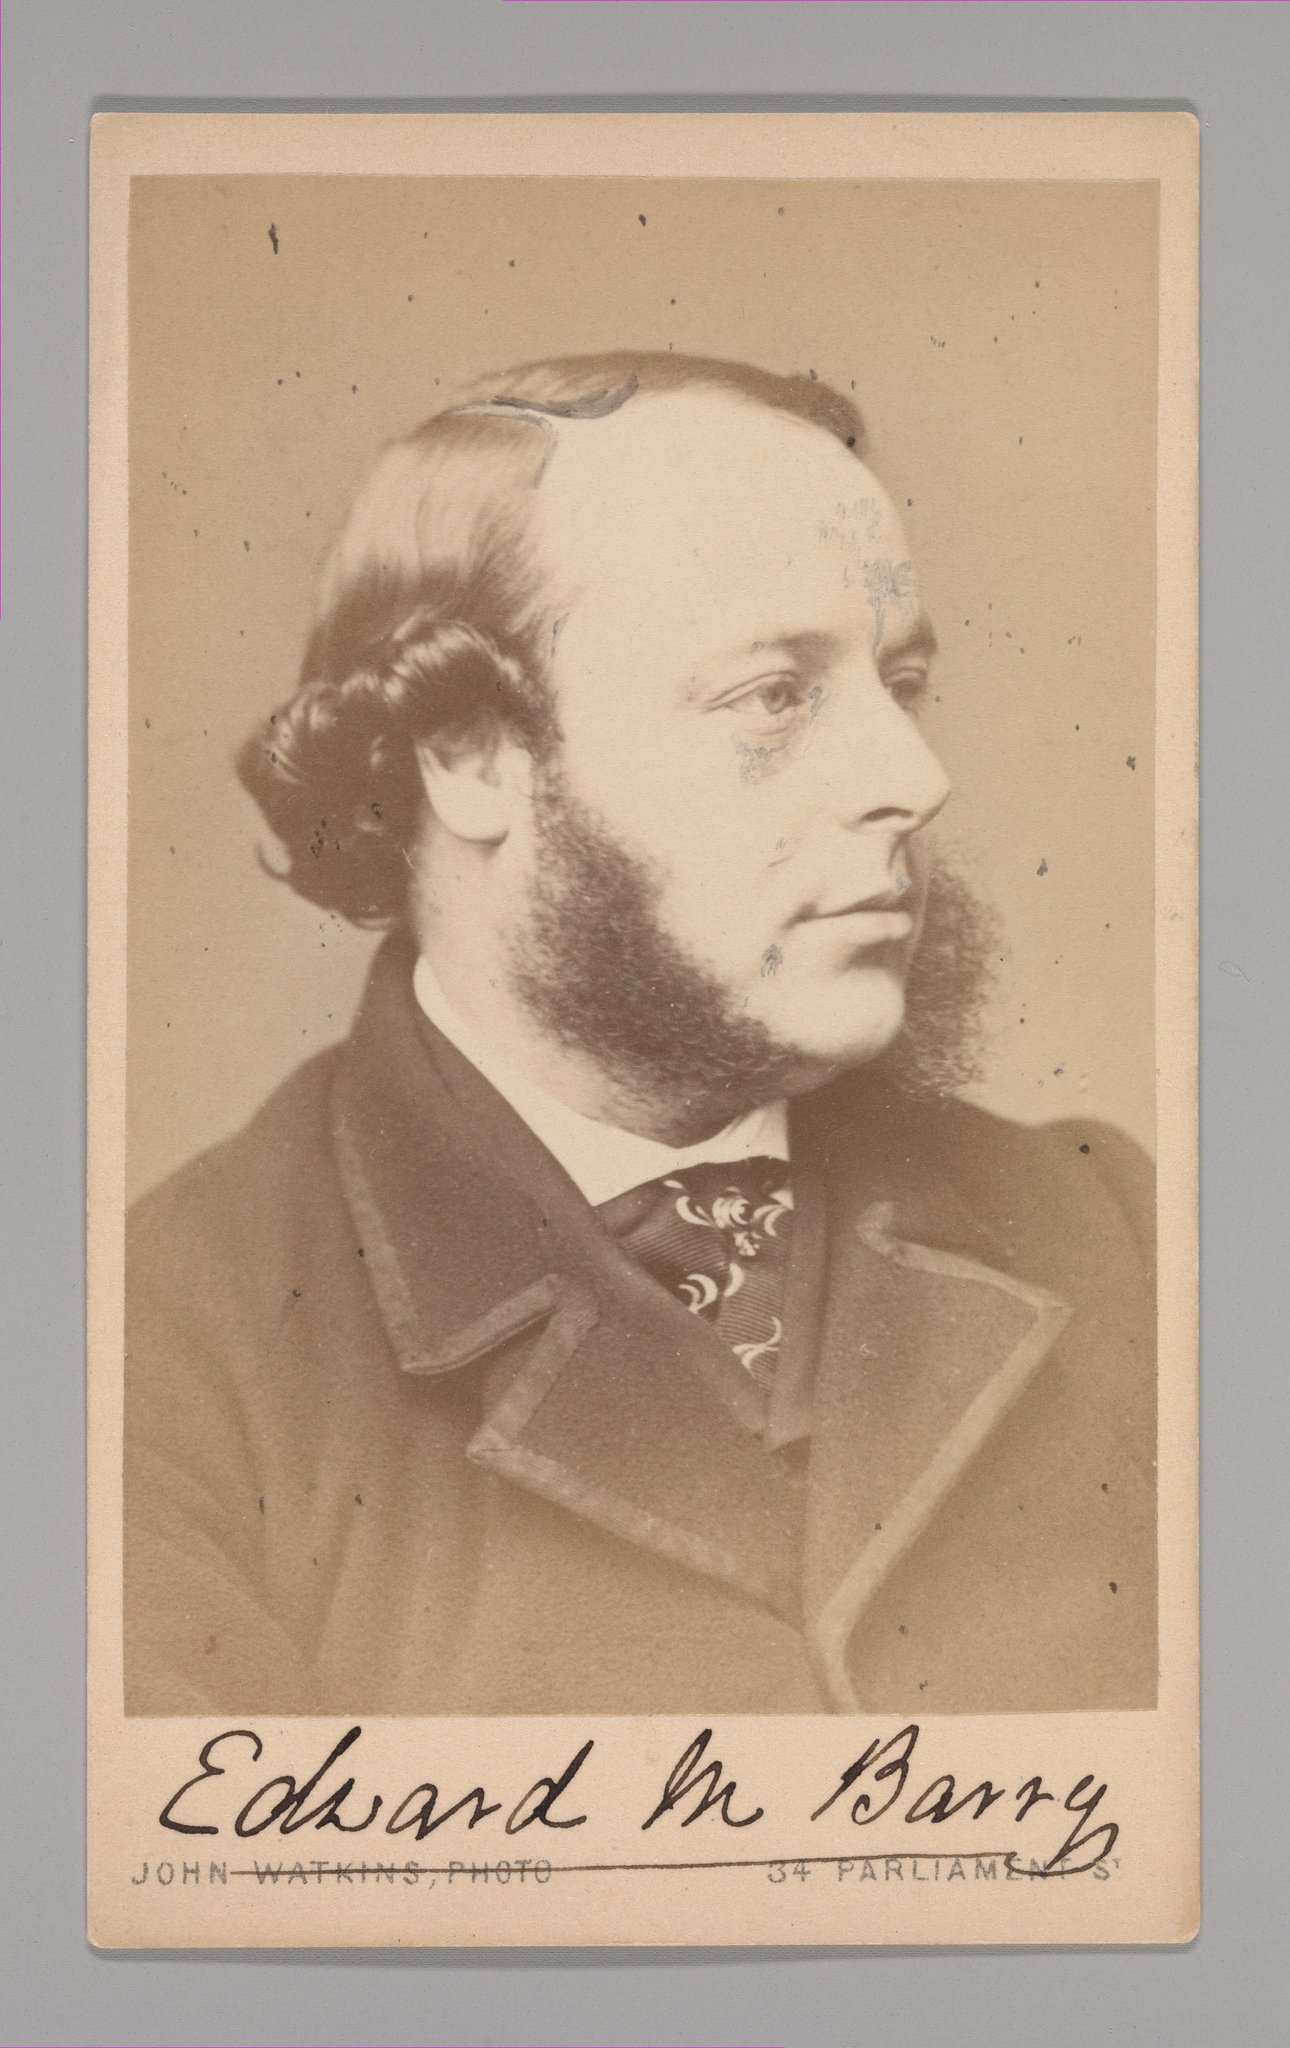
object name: carte de visite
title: [Edward Middleton Barry]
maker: john and charles watkins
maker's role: photography studio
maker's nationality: british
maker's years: 1840-1875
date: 1860-1869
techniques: albumen silver print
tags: men,portraits